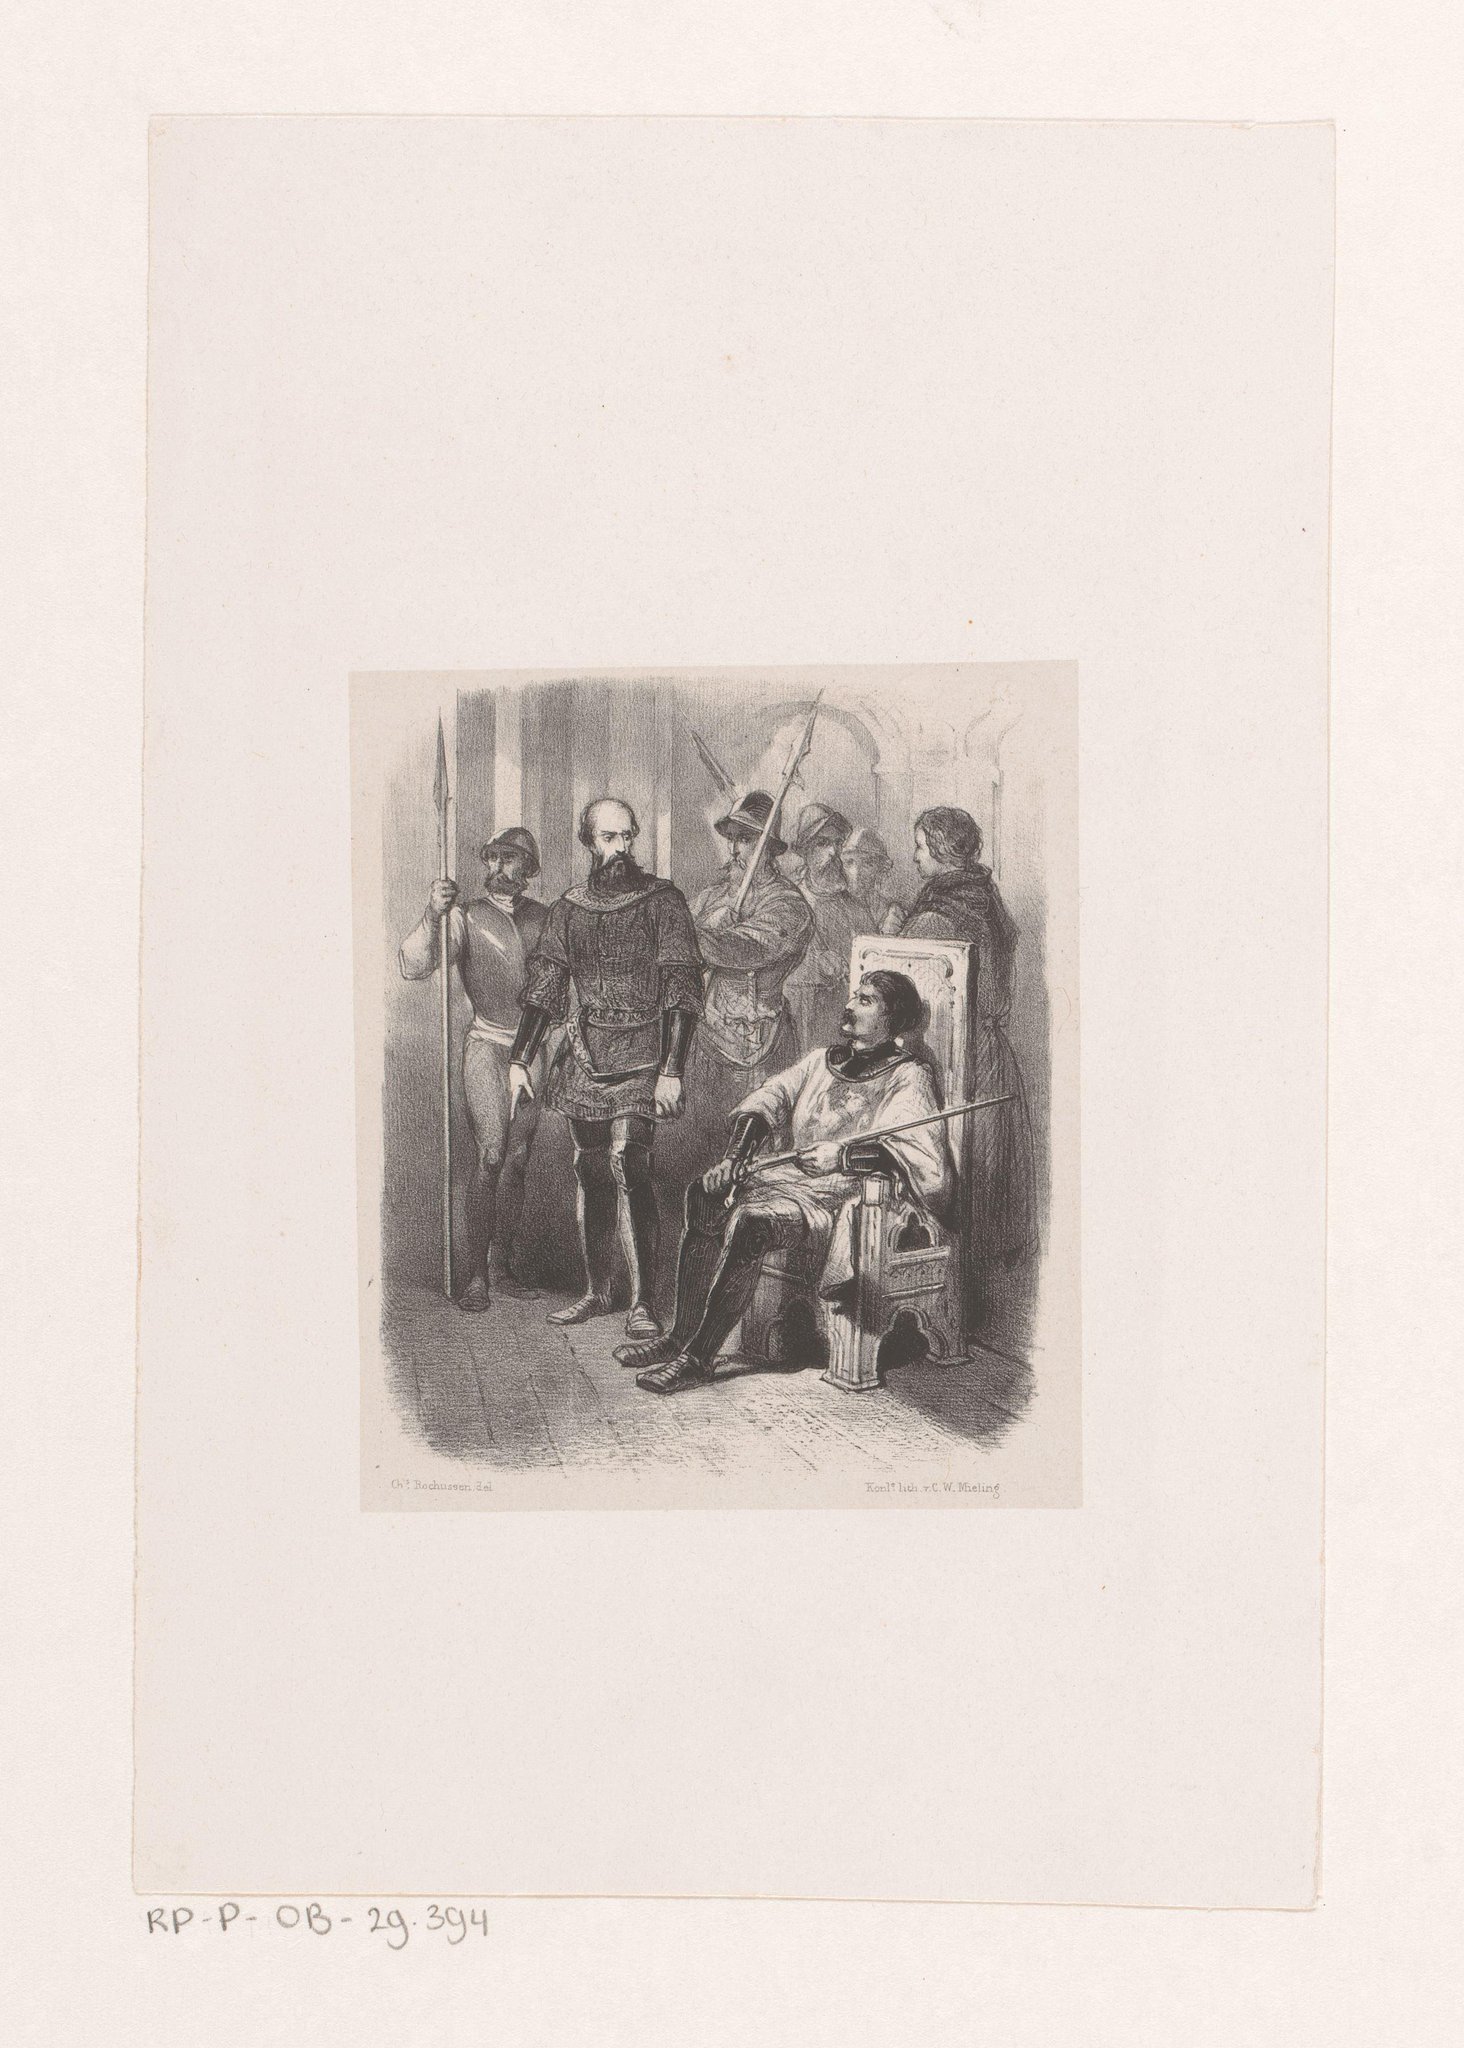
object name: print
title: Geharnaste mannen en monnik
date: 1847-1865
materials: paper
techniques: lithograph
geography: the hague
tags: armour, monk(s), friar(s)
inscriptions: collector's mark: Lugt 2228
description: Een geharnaste man zit in een stoel met een zwaard in de rechterhand. Links staat een eveneens geharnaste man bewaakt door bewapende mannen. Rechts achter de stoel staat een monnik.